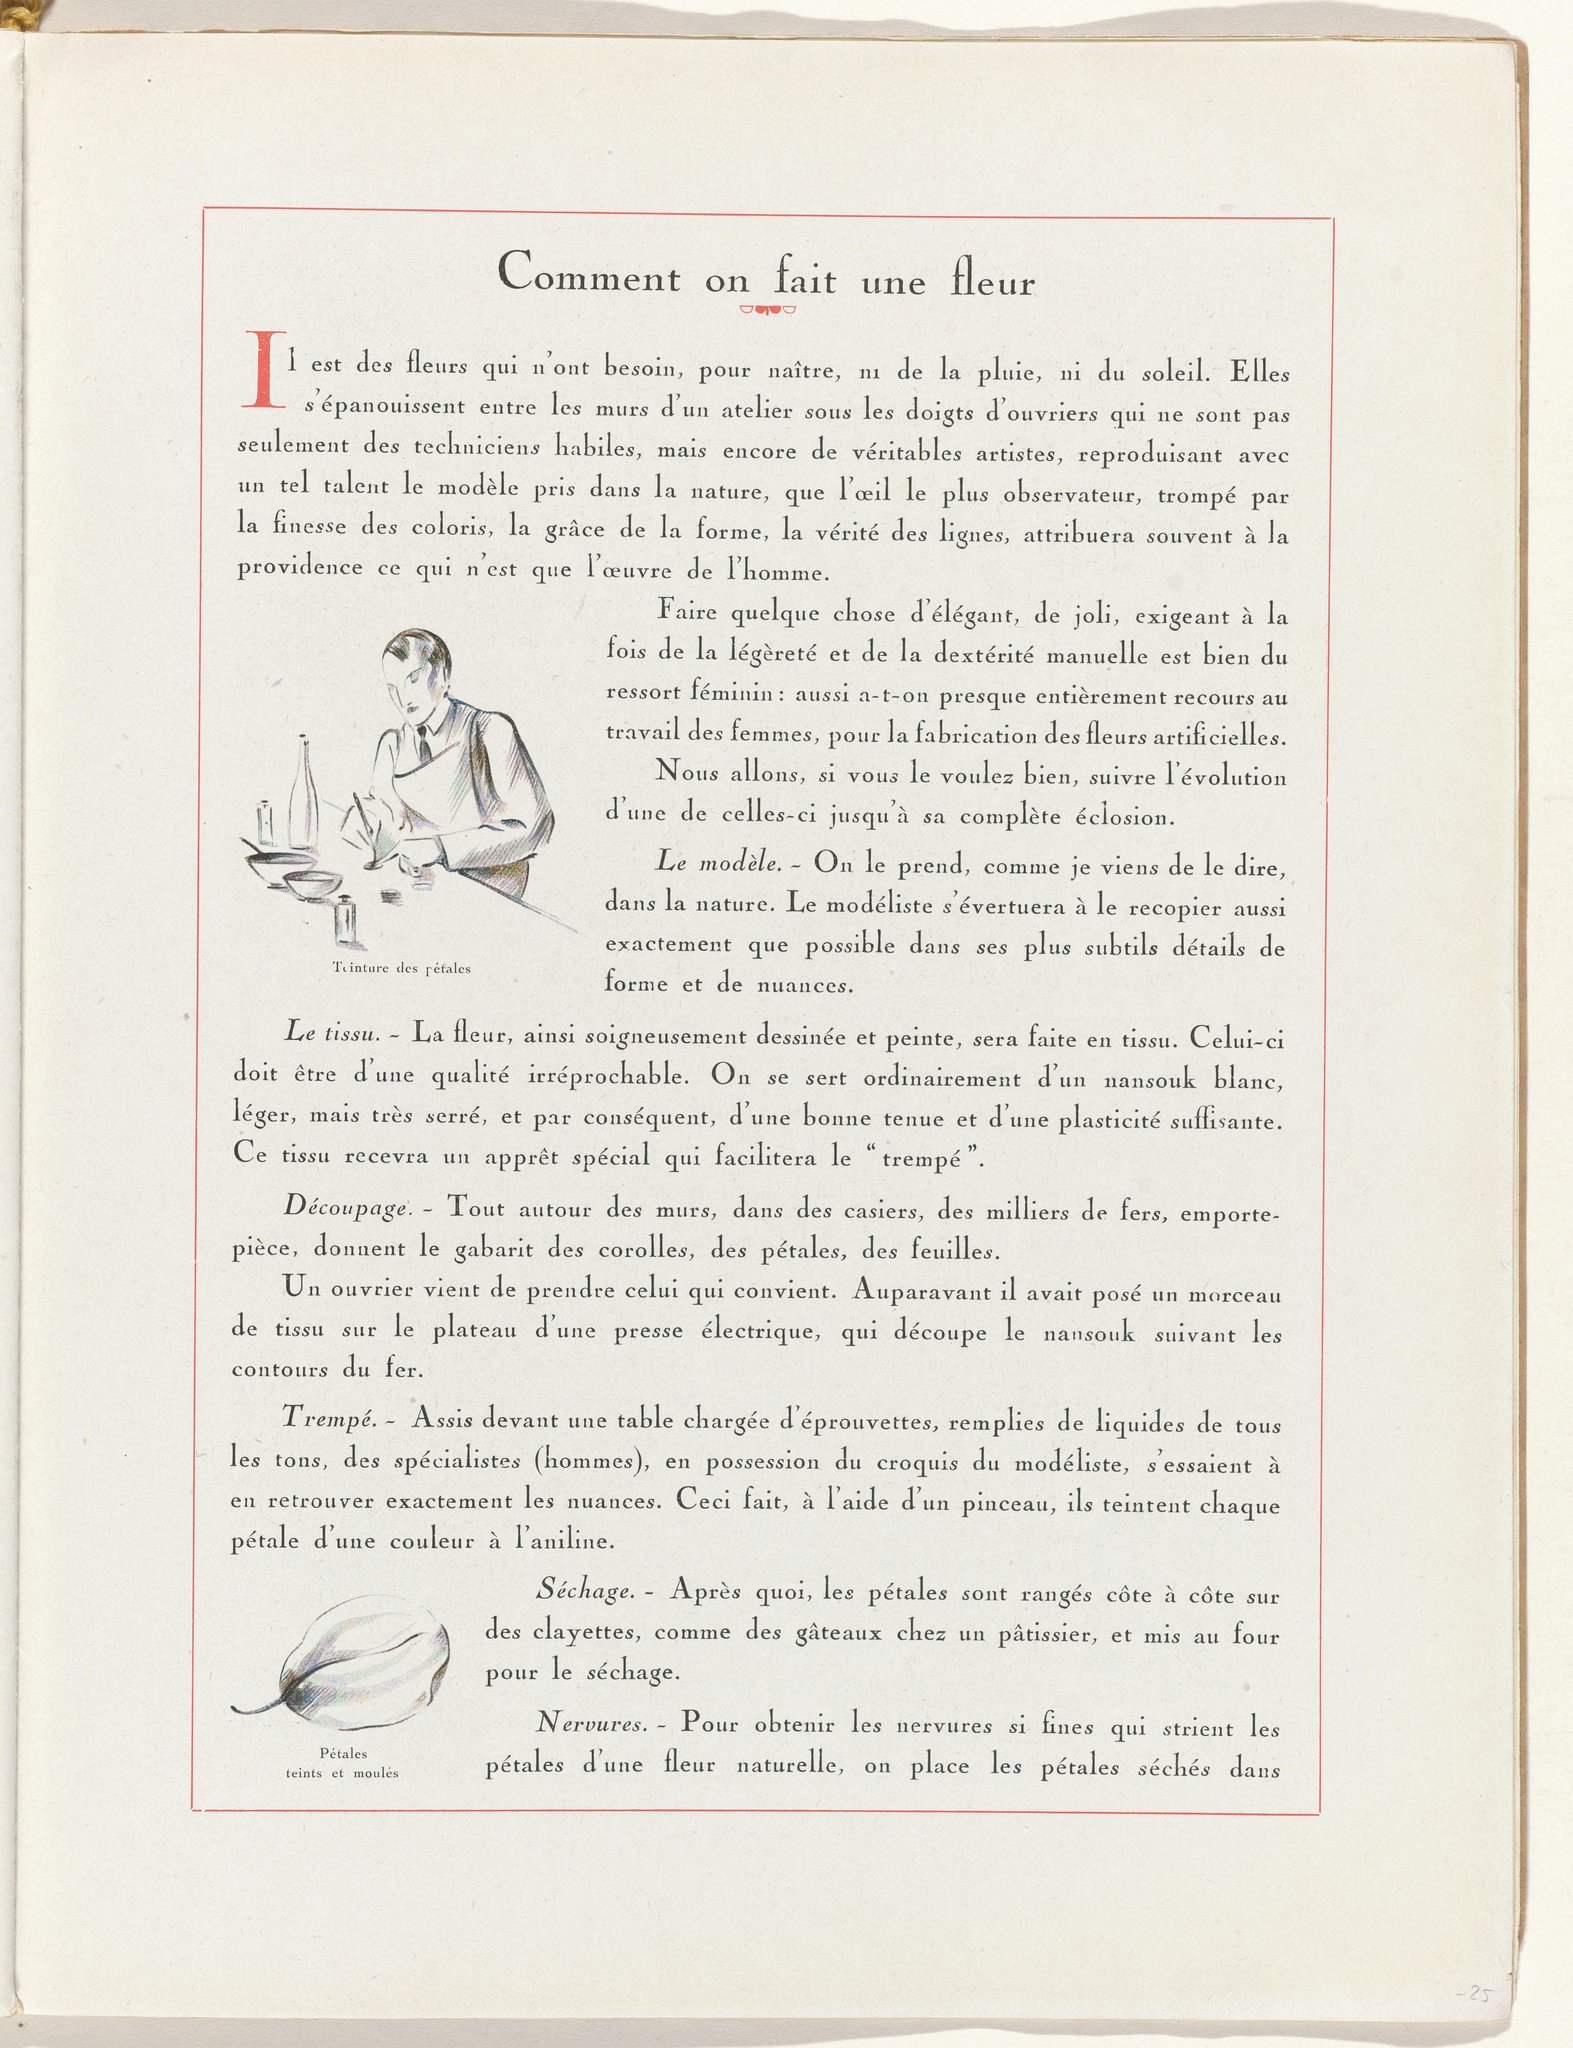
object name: fashion print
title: Art - Goût - Beauté, Feuillets de l' élégance féminine, Mars 1932, No. 139, 12e Année, p. 25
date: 1932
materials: paper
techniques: printing, photography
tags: flowers, fashion plates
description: Tekst 'Comment on fait une fleur' met twee afbeeldingen van een man die bloemblaadjes verft en een geverfd bloemblaadje. Pagina uit het modetijdschrift Art-Goût-Beauté (1920-1933).